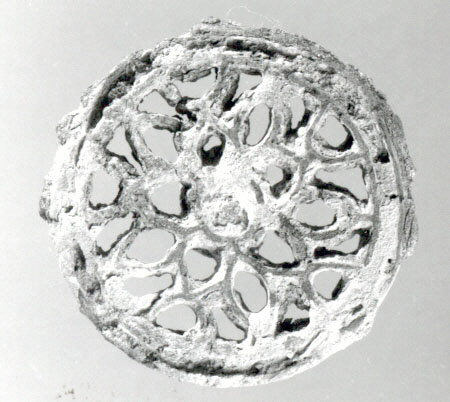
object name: stamp seal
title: Compartmented stamp seal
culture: bactria-margiana archaeological complex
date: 2333-1668 BCE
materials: copper alloy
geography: bactria-margiana